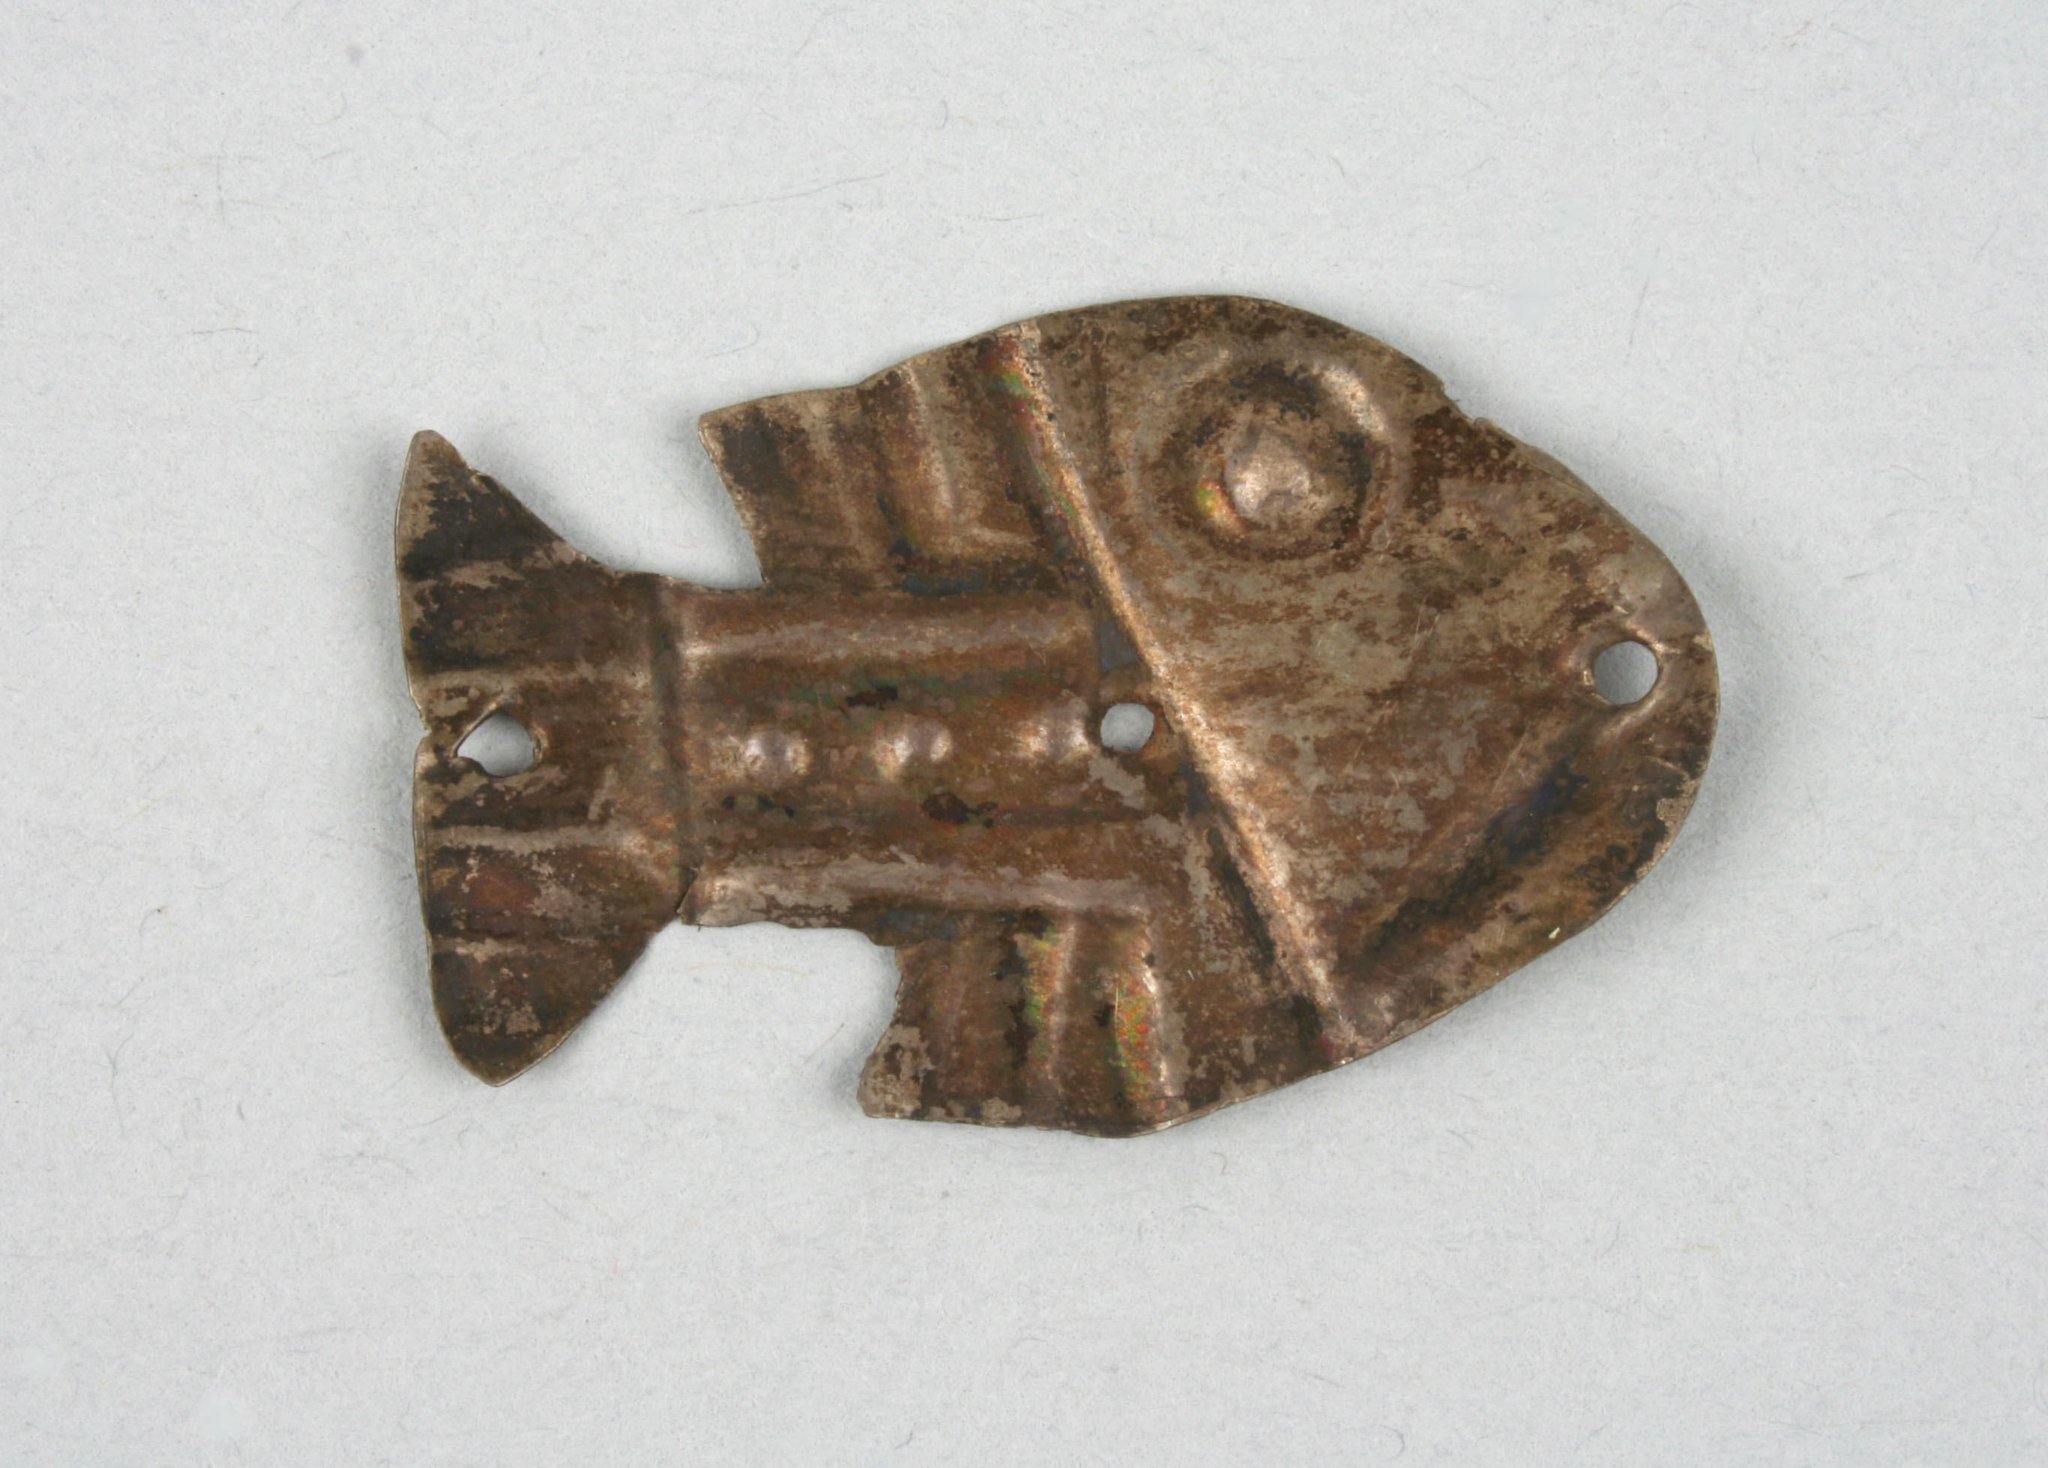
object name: ornament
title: Costume Ornament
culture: central coast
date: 1001-1200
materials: silver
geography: peru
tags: fish